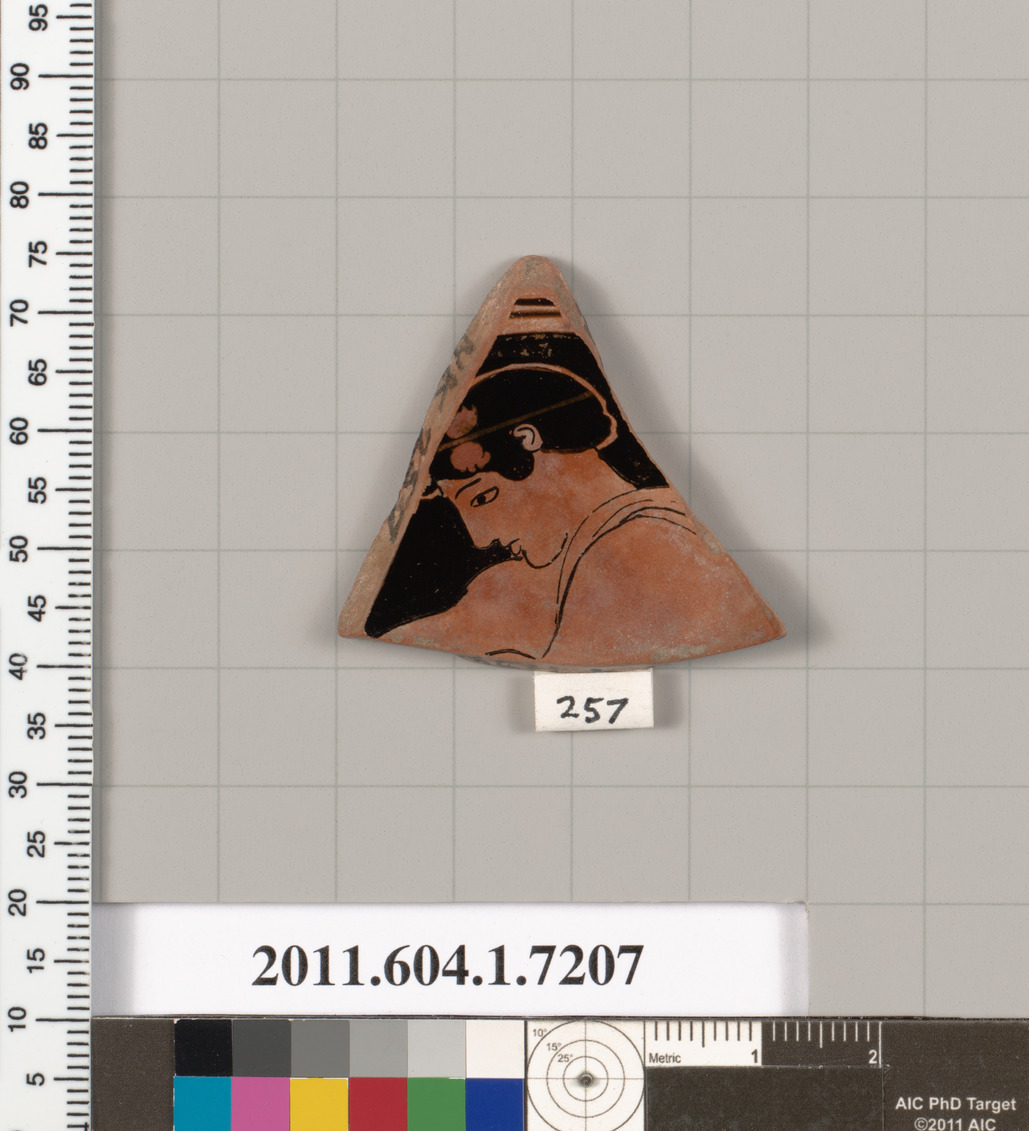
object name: kylix fragment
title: Terracotta fragment of a kylix (drinking cup)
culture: greek, attic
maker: makron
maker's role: artist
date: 500-480 BCE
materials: terracotta